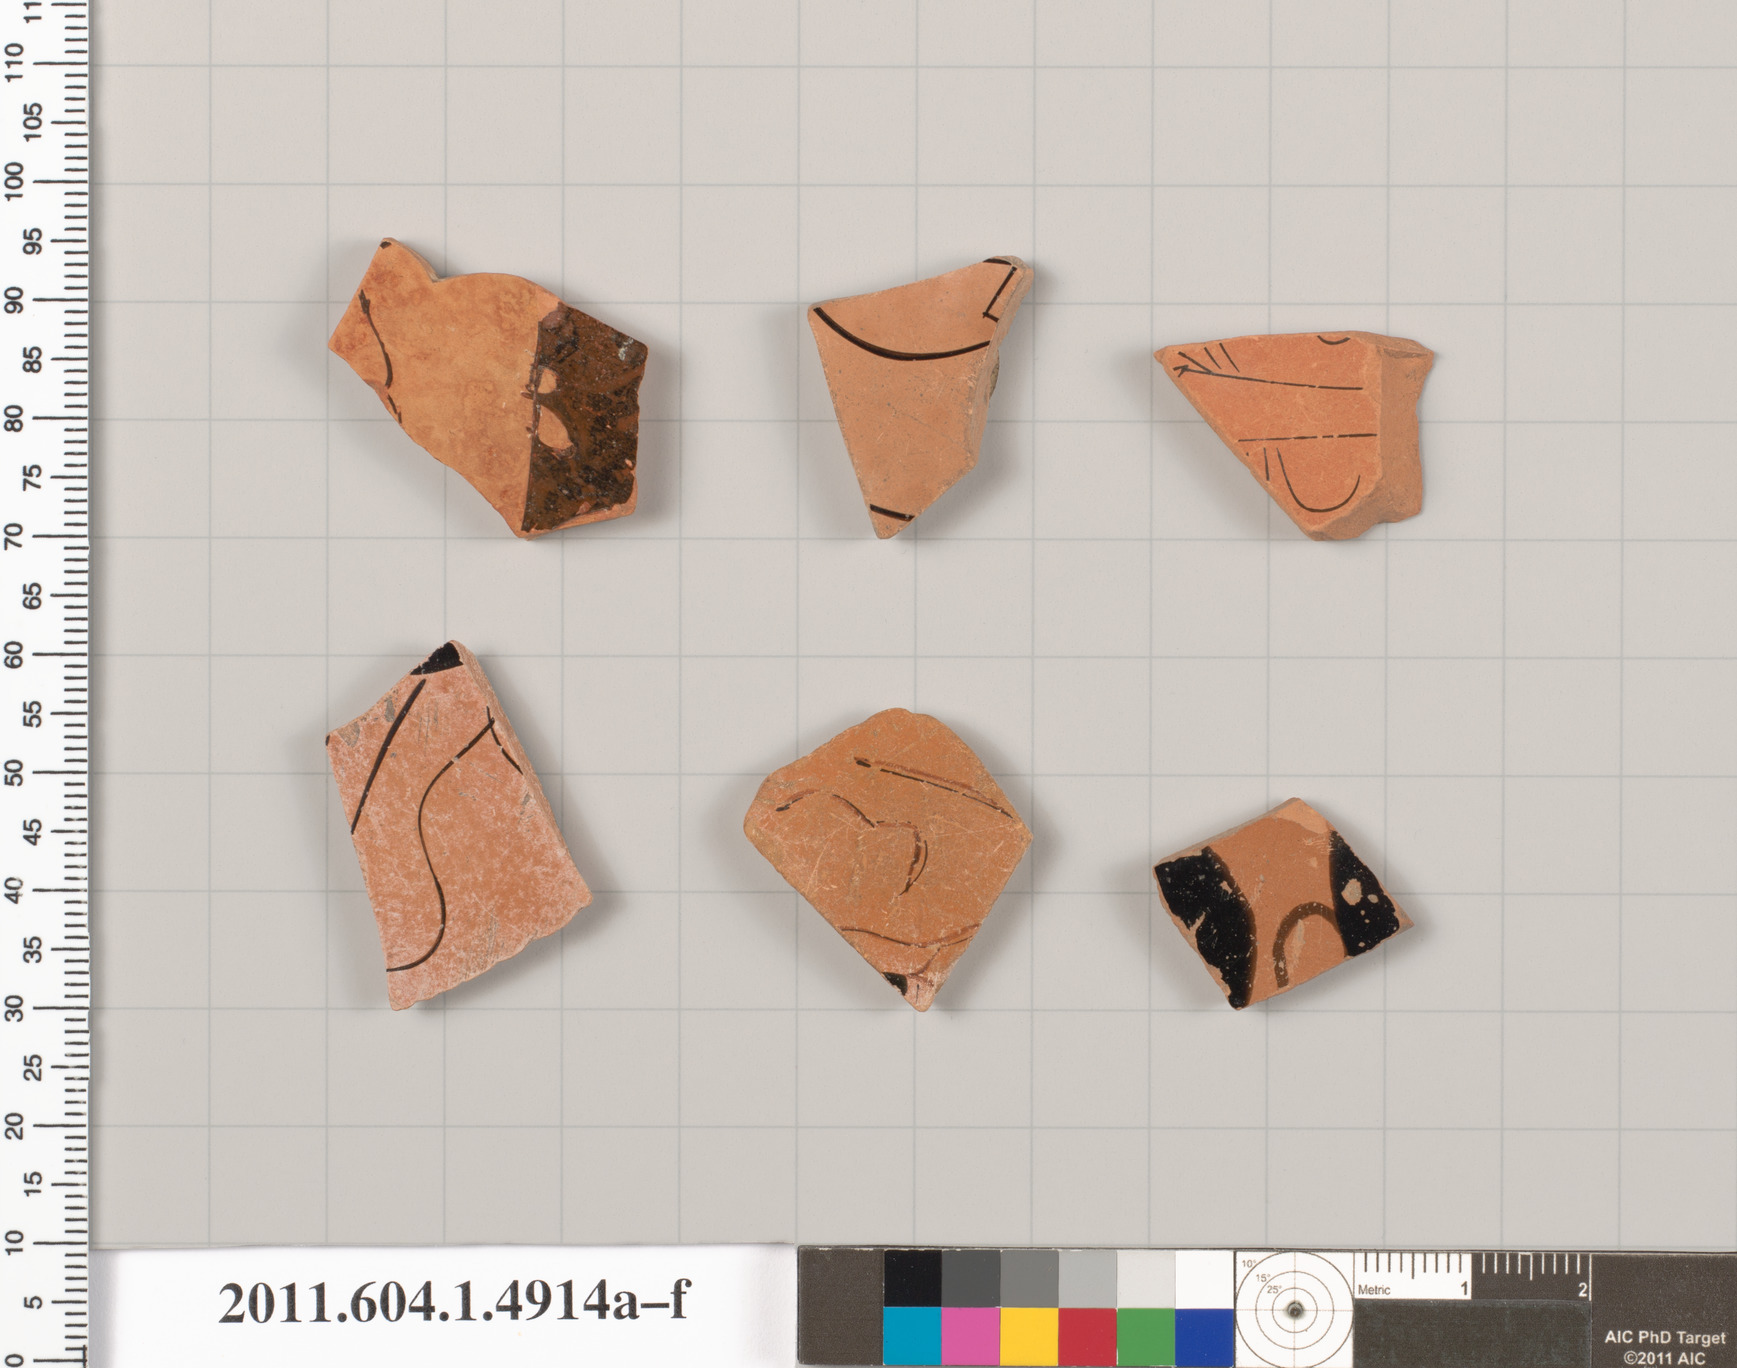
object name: kylix fragment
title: Terracotta fragments of kylikes (drinking cups)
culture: greek, attic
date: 600-401 BCE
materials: terracotta